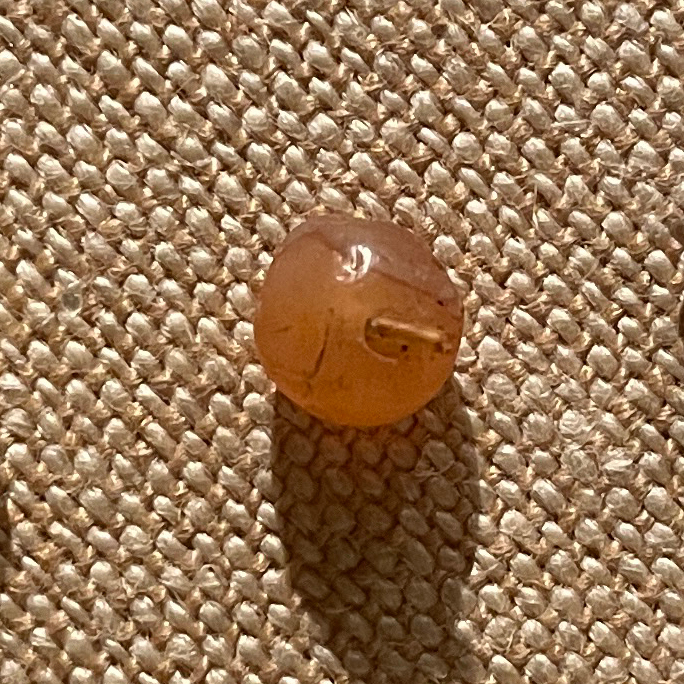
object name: bead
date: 701-1300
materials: stone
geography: iran